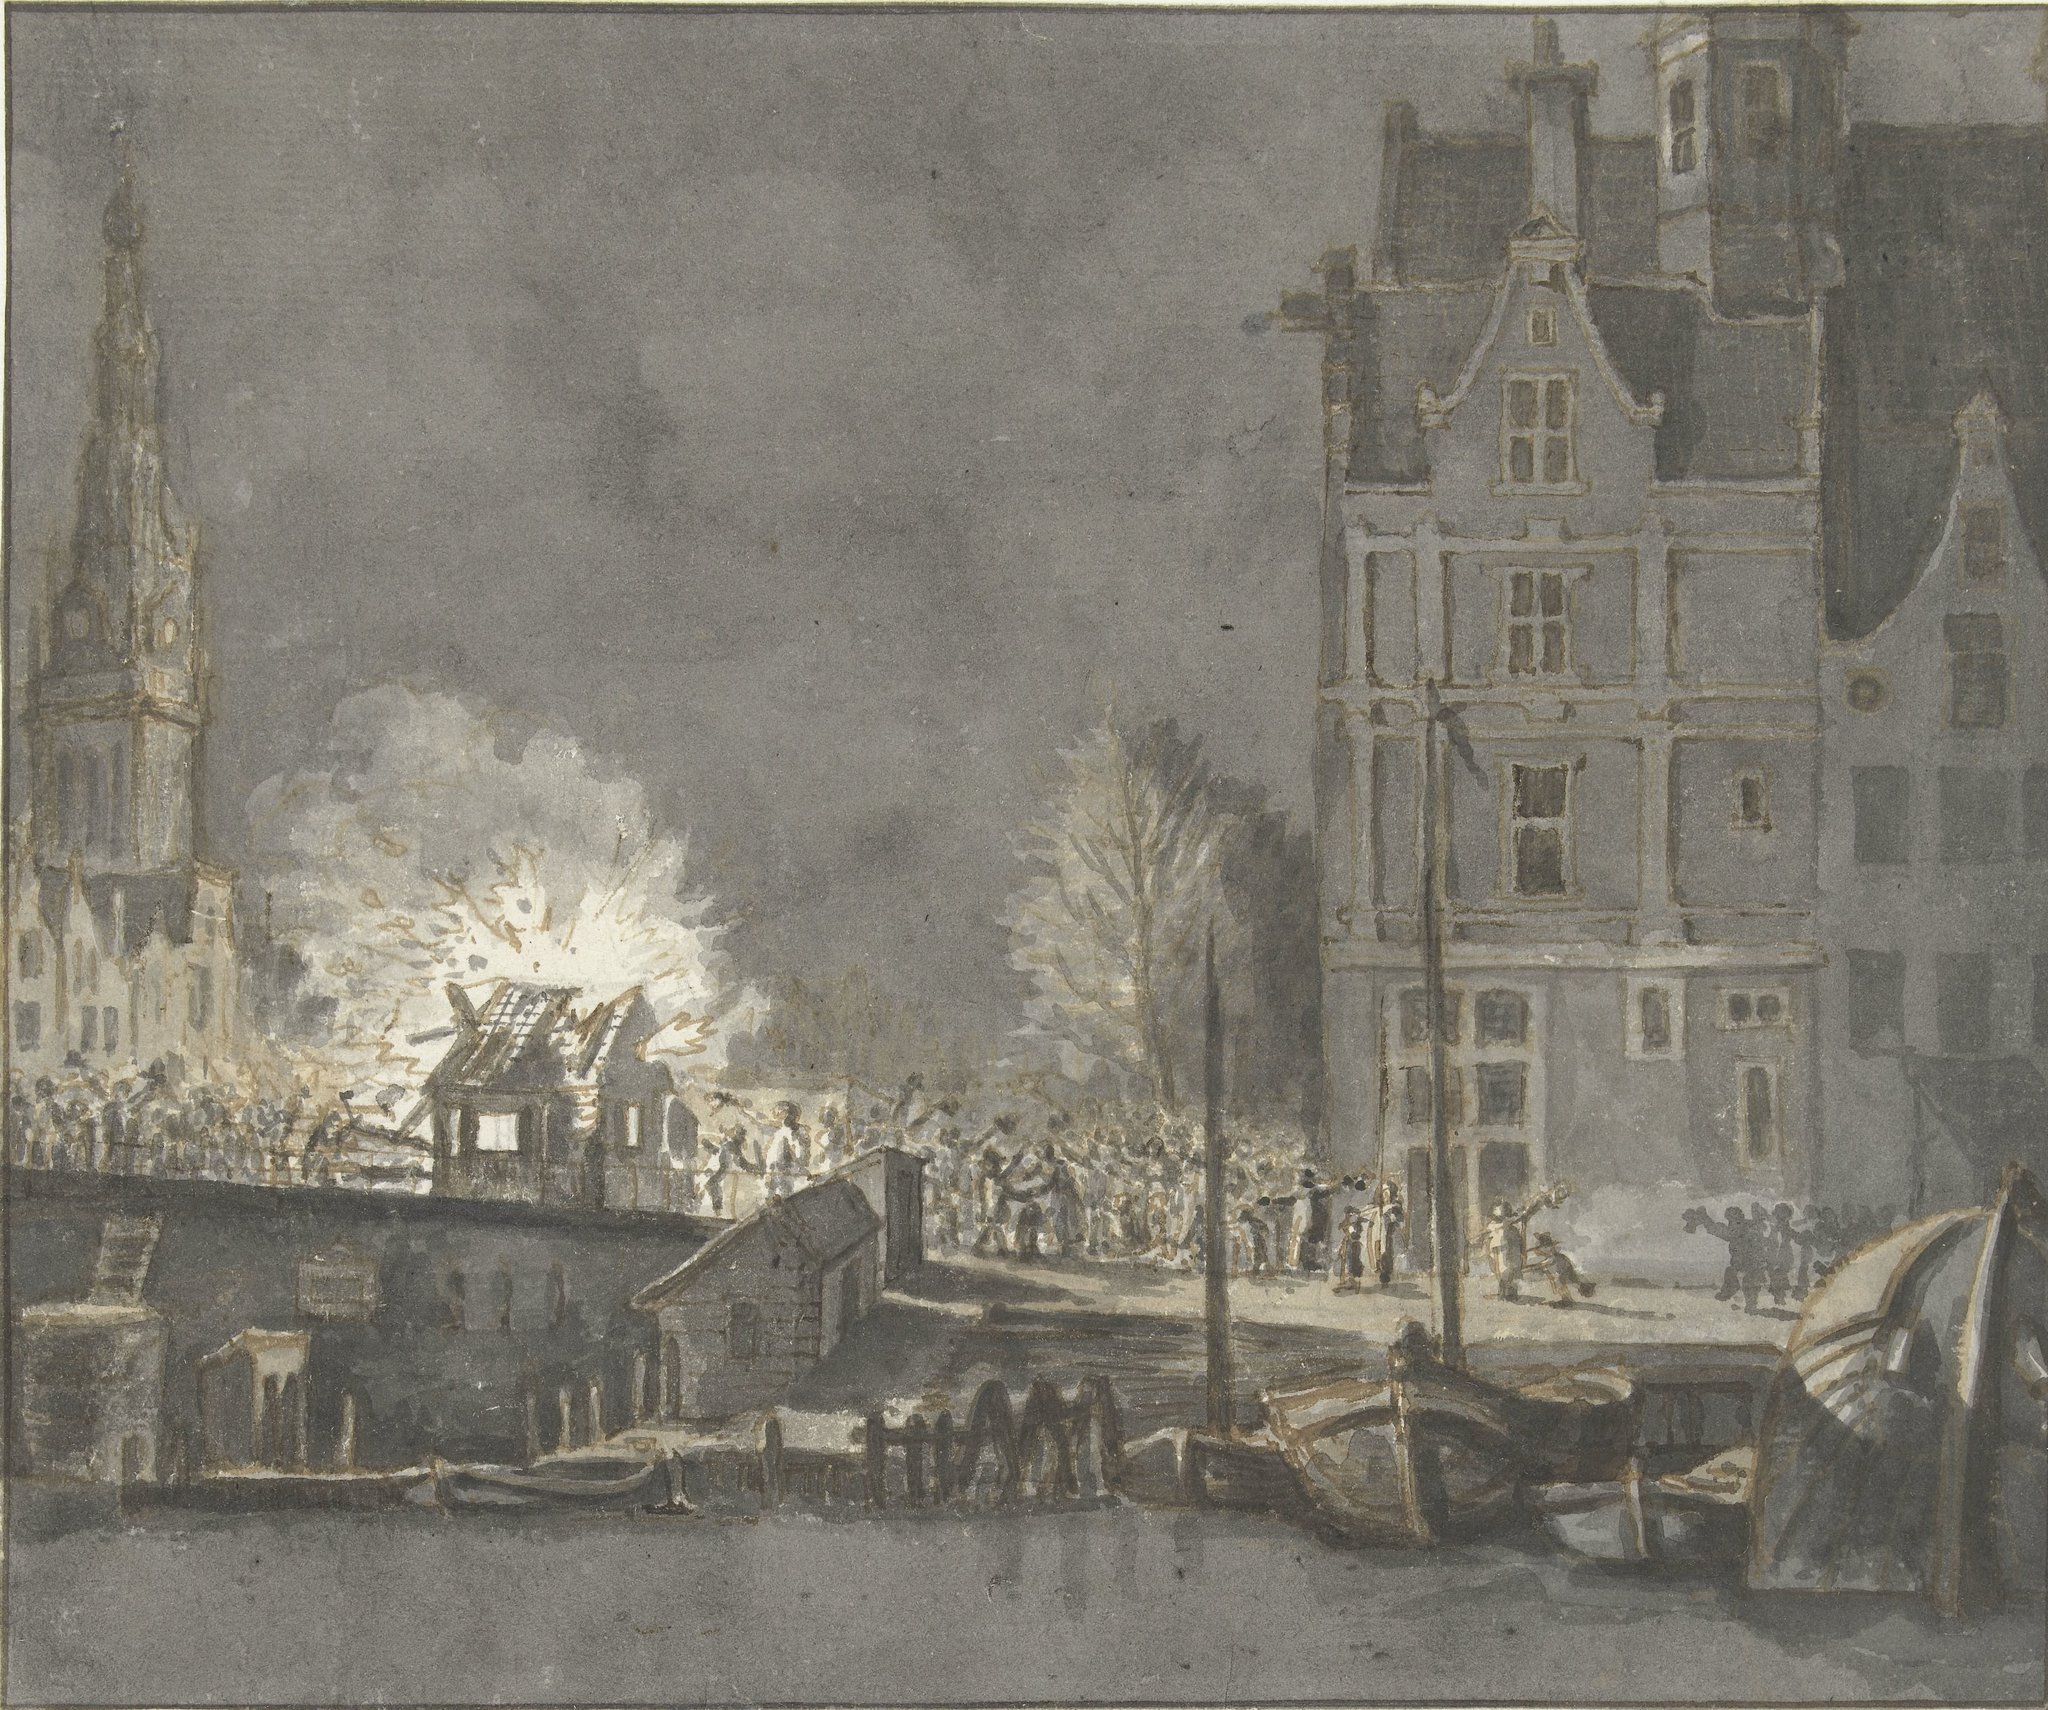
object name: drawing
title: Verbranden der douanehuisjes bij de Nieuwebrug te Amsterdam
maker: gerrit lamberts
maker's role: bookseller, draughtsman, print maker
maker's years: 1776-1850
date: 1811-1813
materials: paper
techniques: brush, pen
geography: amsterdam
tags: street-fights, riots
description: Het verbranden van de Franse douanehuisjes bij de Nieuwebrug te Amsterdam op 15 november 1813. Links een douanehuis in brand, eromheen een joelende menigte.